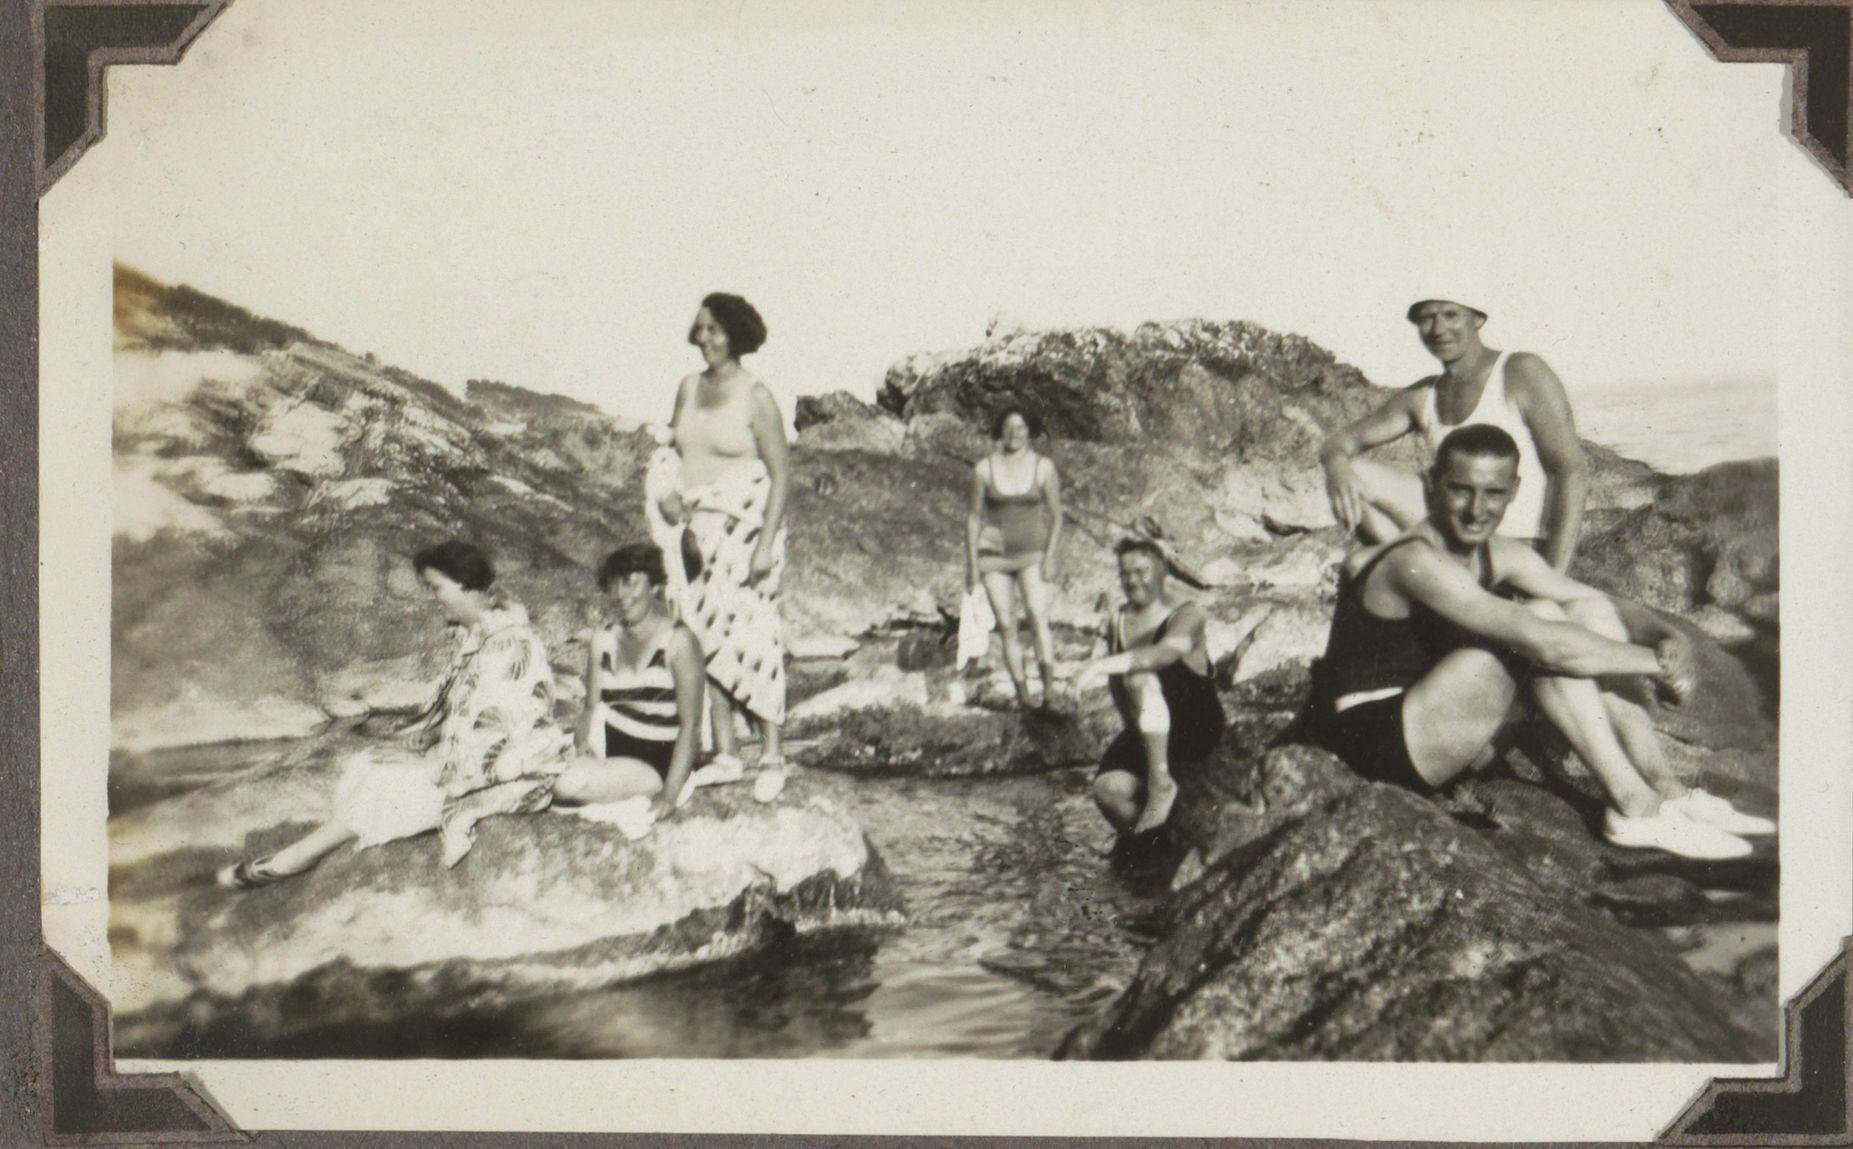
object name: photograph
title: Gezelschap in zwemkleding op een rots bij Roquebrune-Cap-Martin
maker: Anonymous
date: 1930-1935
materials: photographic support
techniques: gelatin silver print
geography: roquebrune-cap-martin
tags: swimming (sport) (+ equipment, outfit (sports, games, etc.))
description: Onderdeel van Fotoalbum met opnames van vakanties in Zuid-Frankrijk.